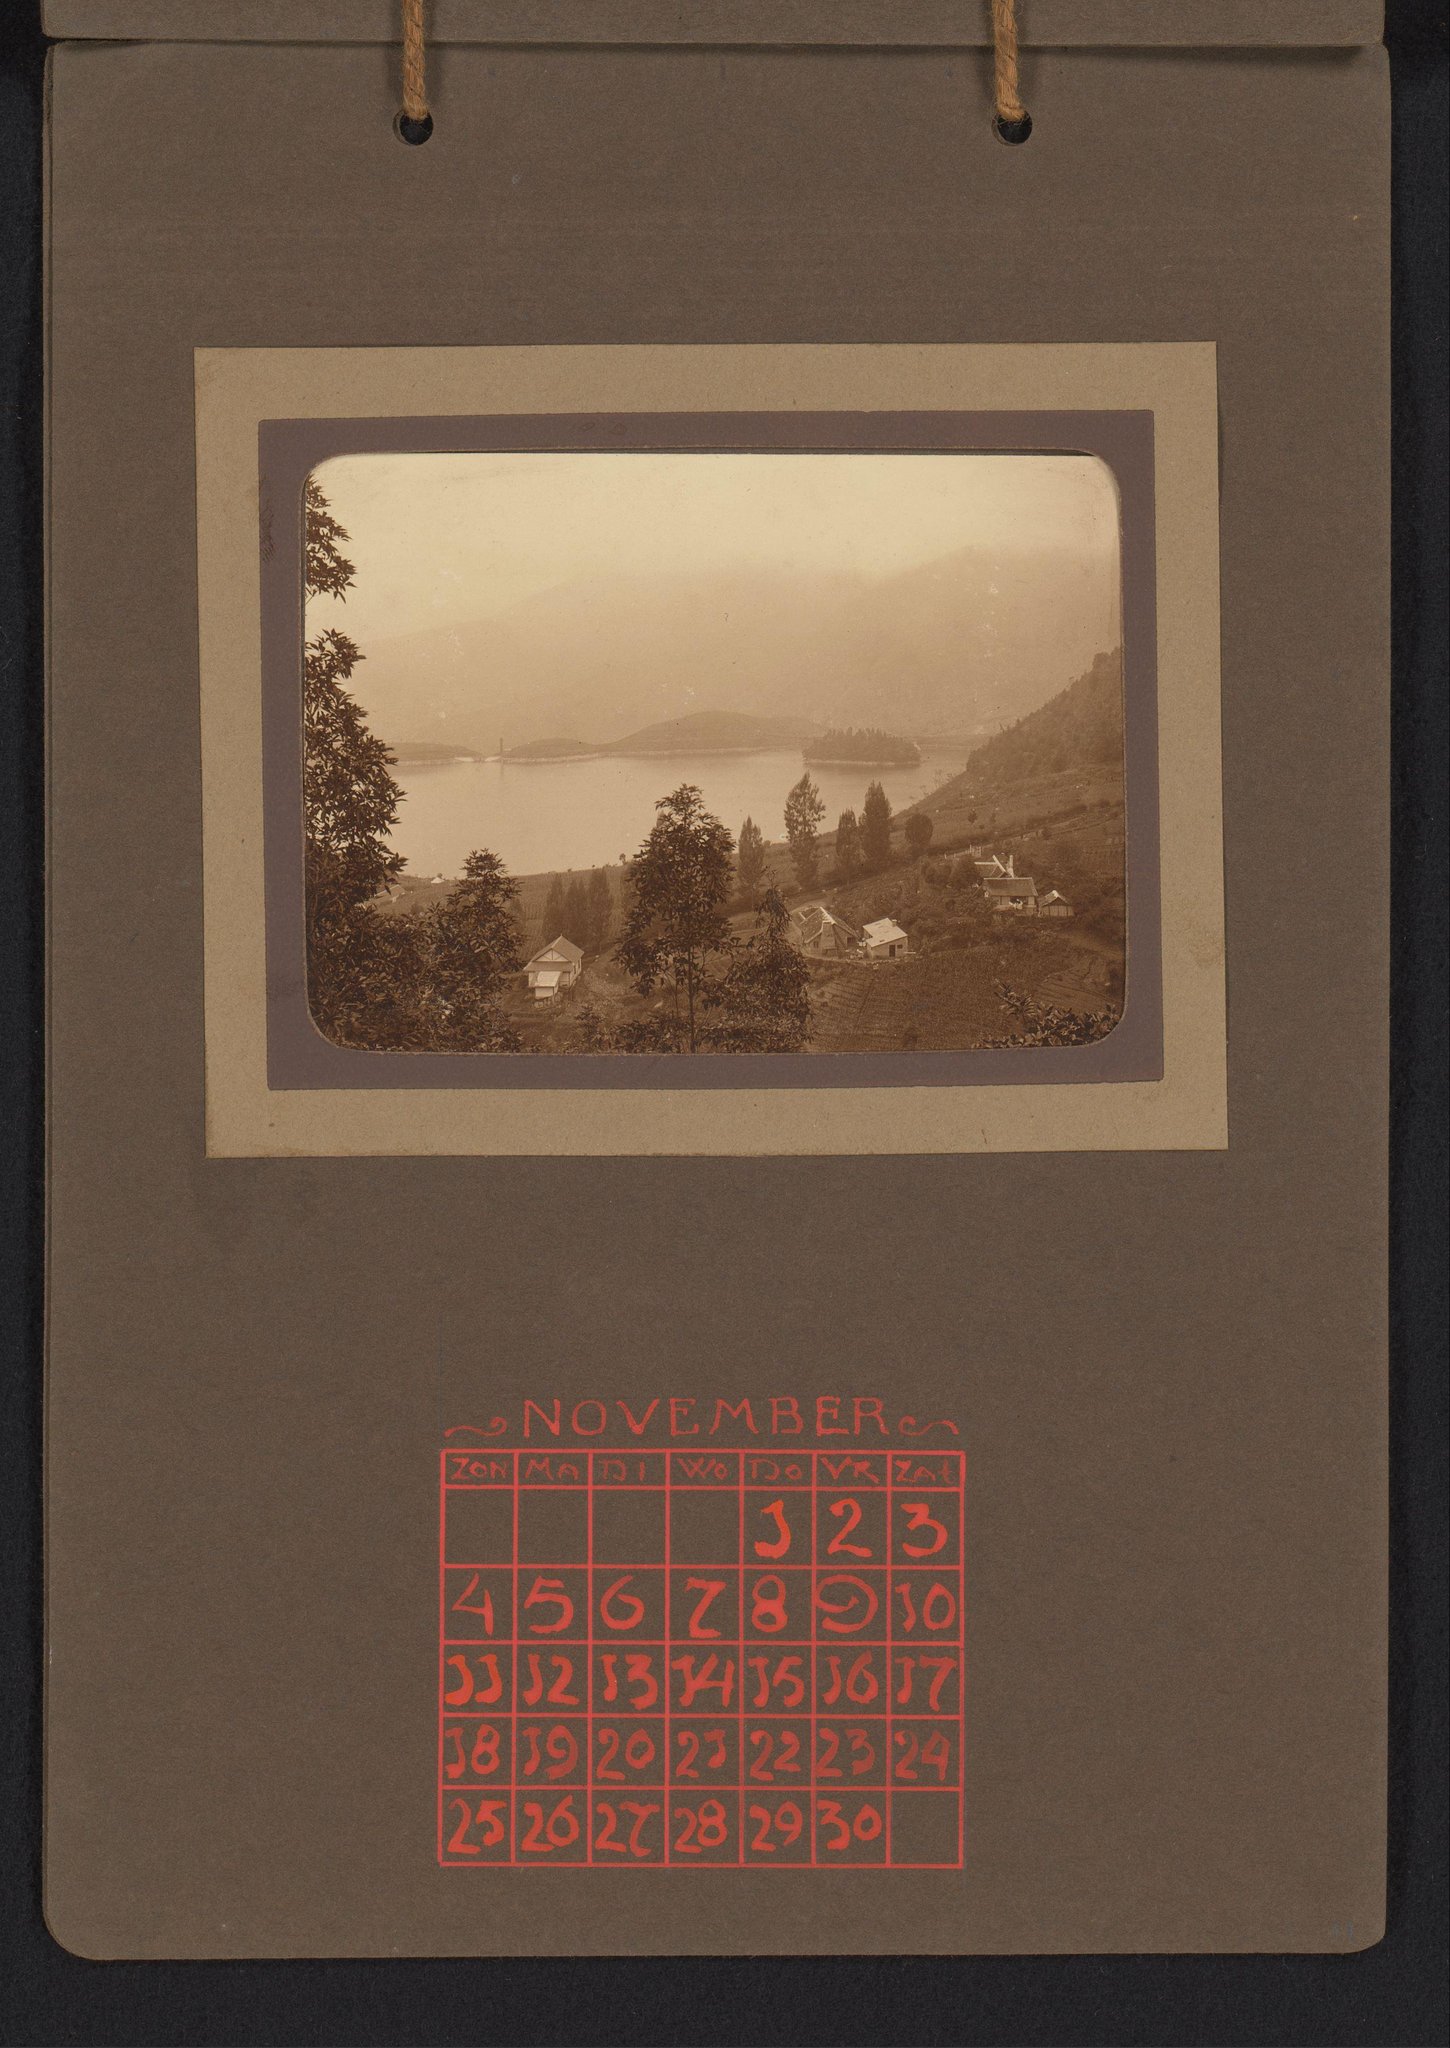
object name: photograph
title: Gezicht op een baai, met op de voorgrond enkele huizen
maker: Anonymous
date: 1880-1923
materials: cardboard, paper, photographic support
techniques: collodion silver print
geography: indonesia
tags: gulf, bay, rural housing, e.g. country-house, villa, cottage, indonesia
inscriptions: annotation: ‘NOVEMBER/ (...)’